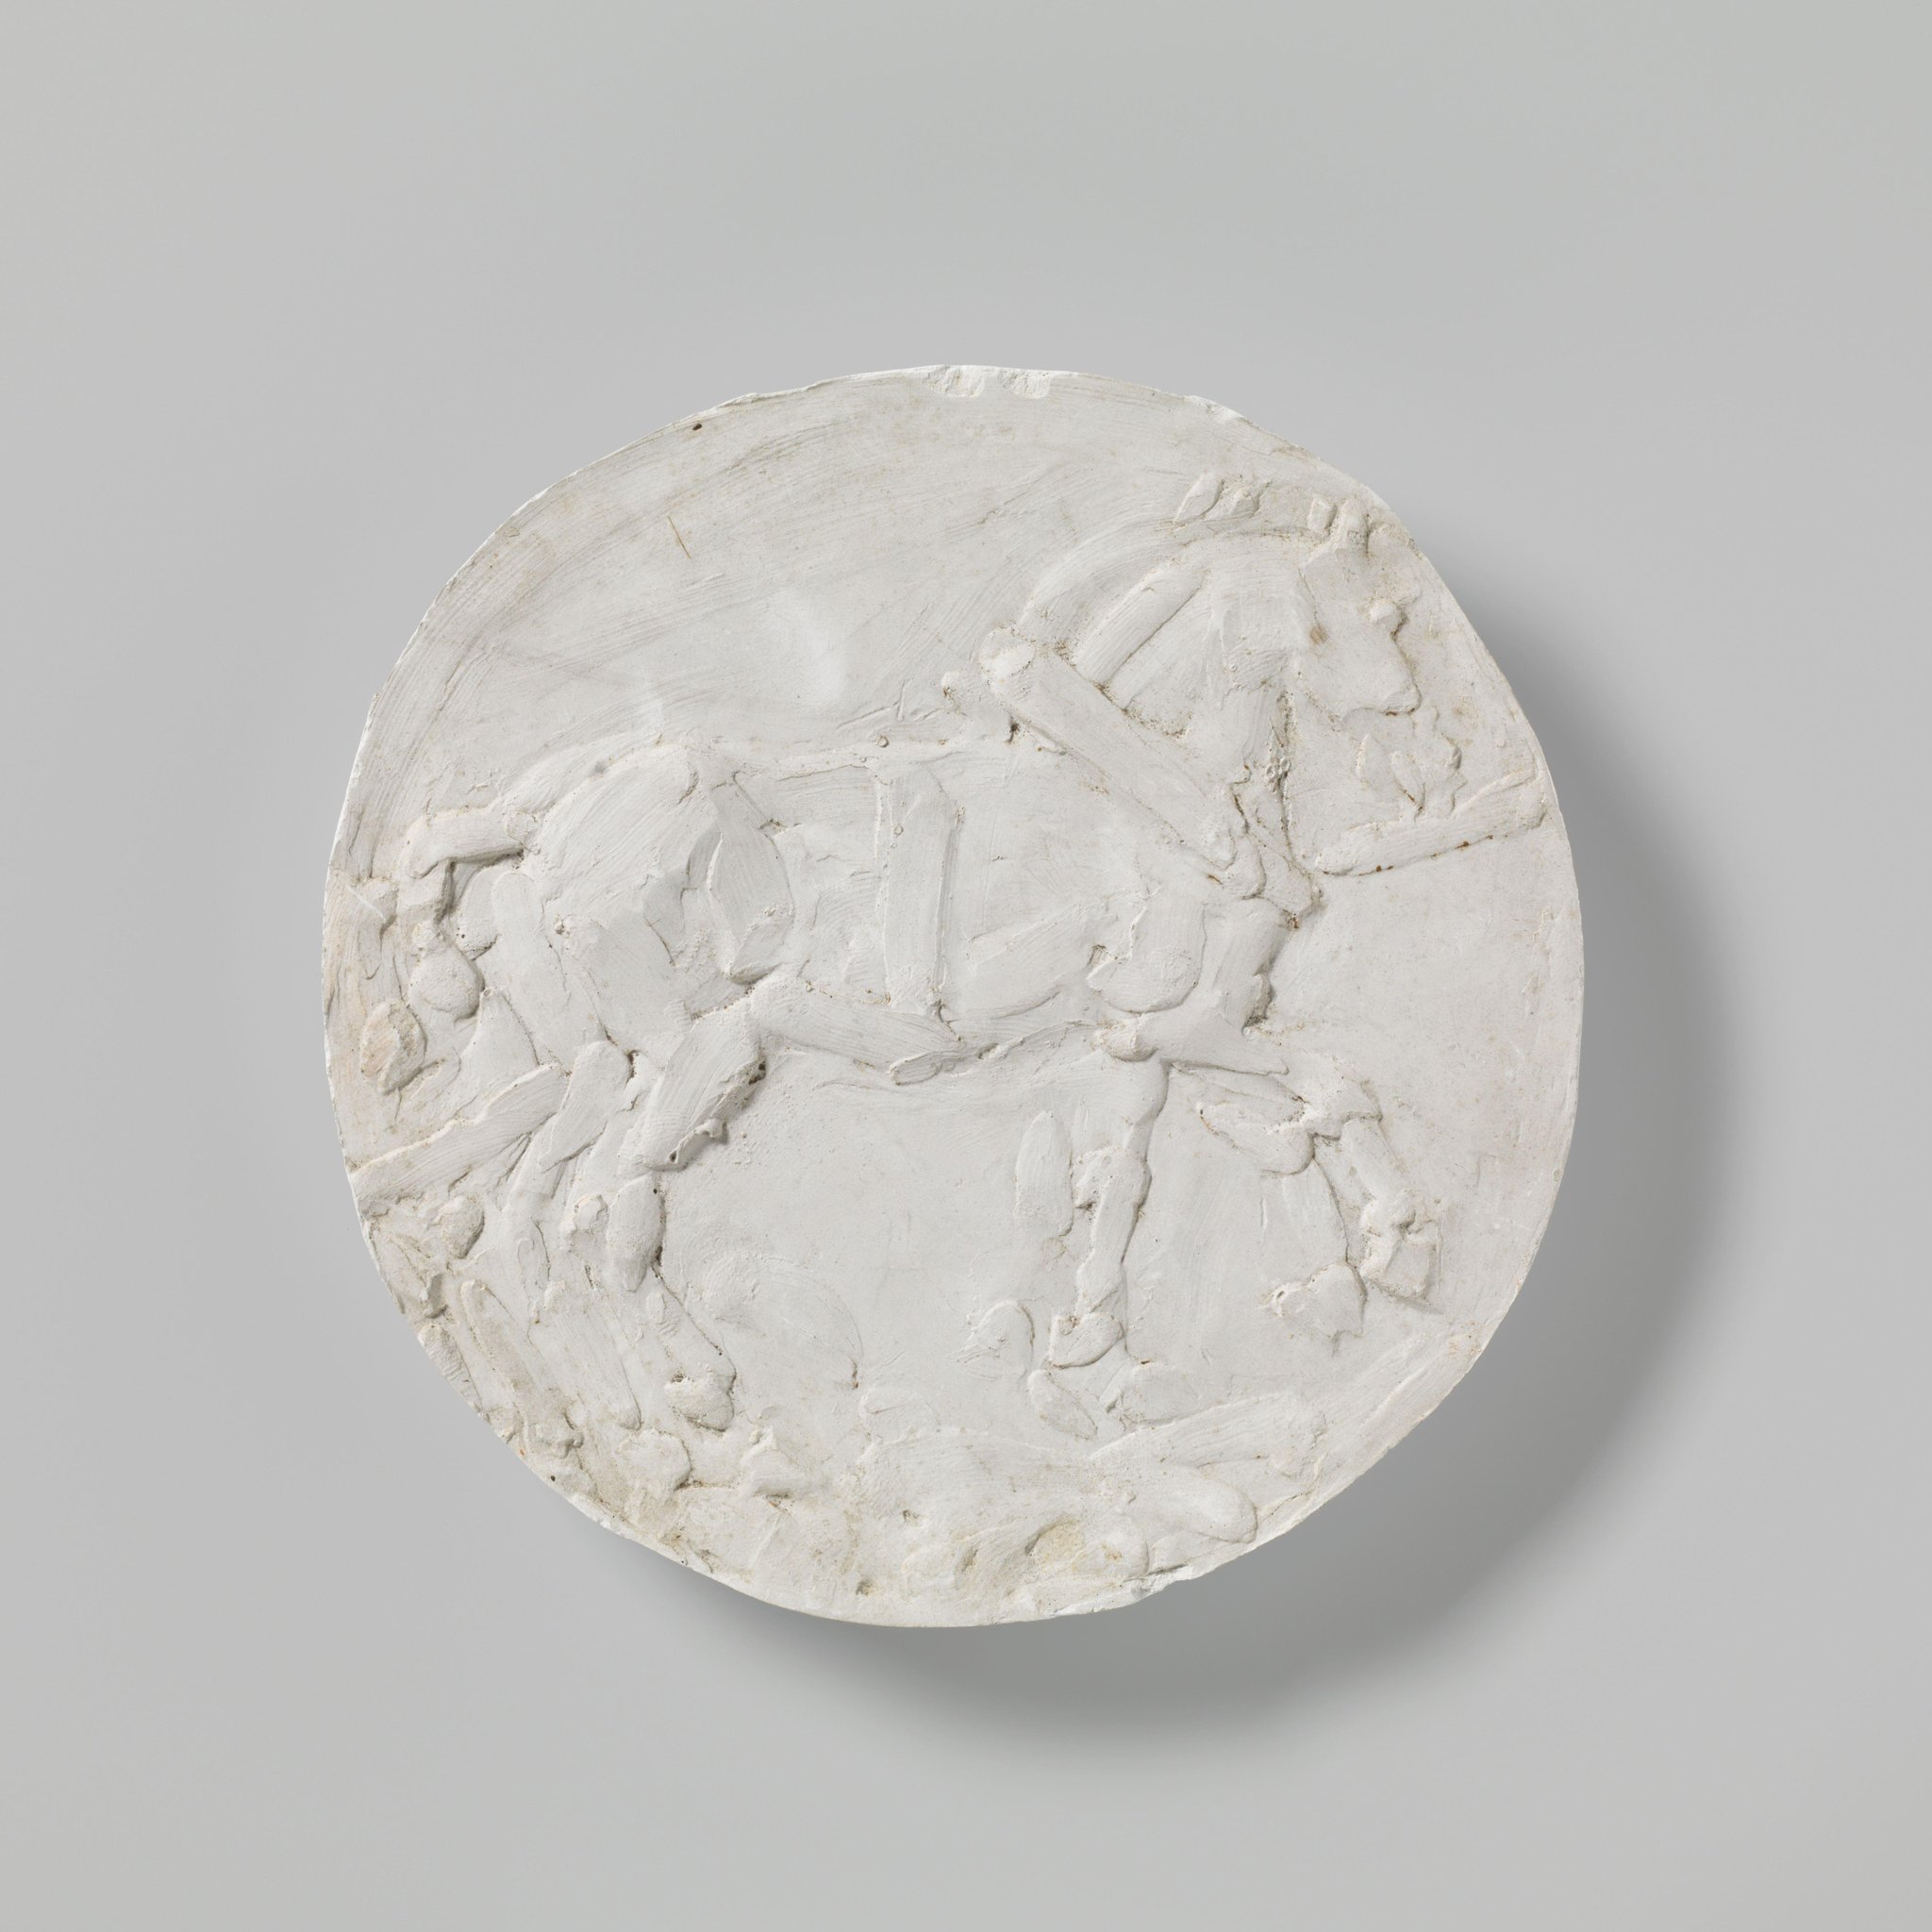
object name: design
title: Ontwerp voor een penning (?) van gips met een paard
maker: lambertus zijl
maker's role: designer, draughtsman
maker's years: 1866-1947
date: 1876-1947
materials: gypsum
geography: netherlands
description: Ontwerp voor een penning (?) van gips met een paard.